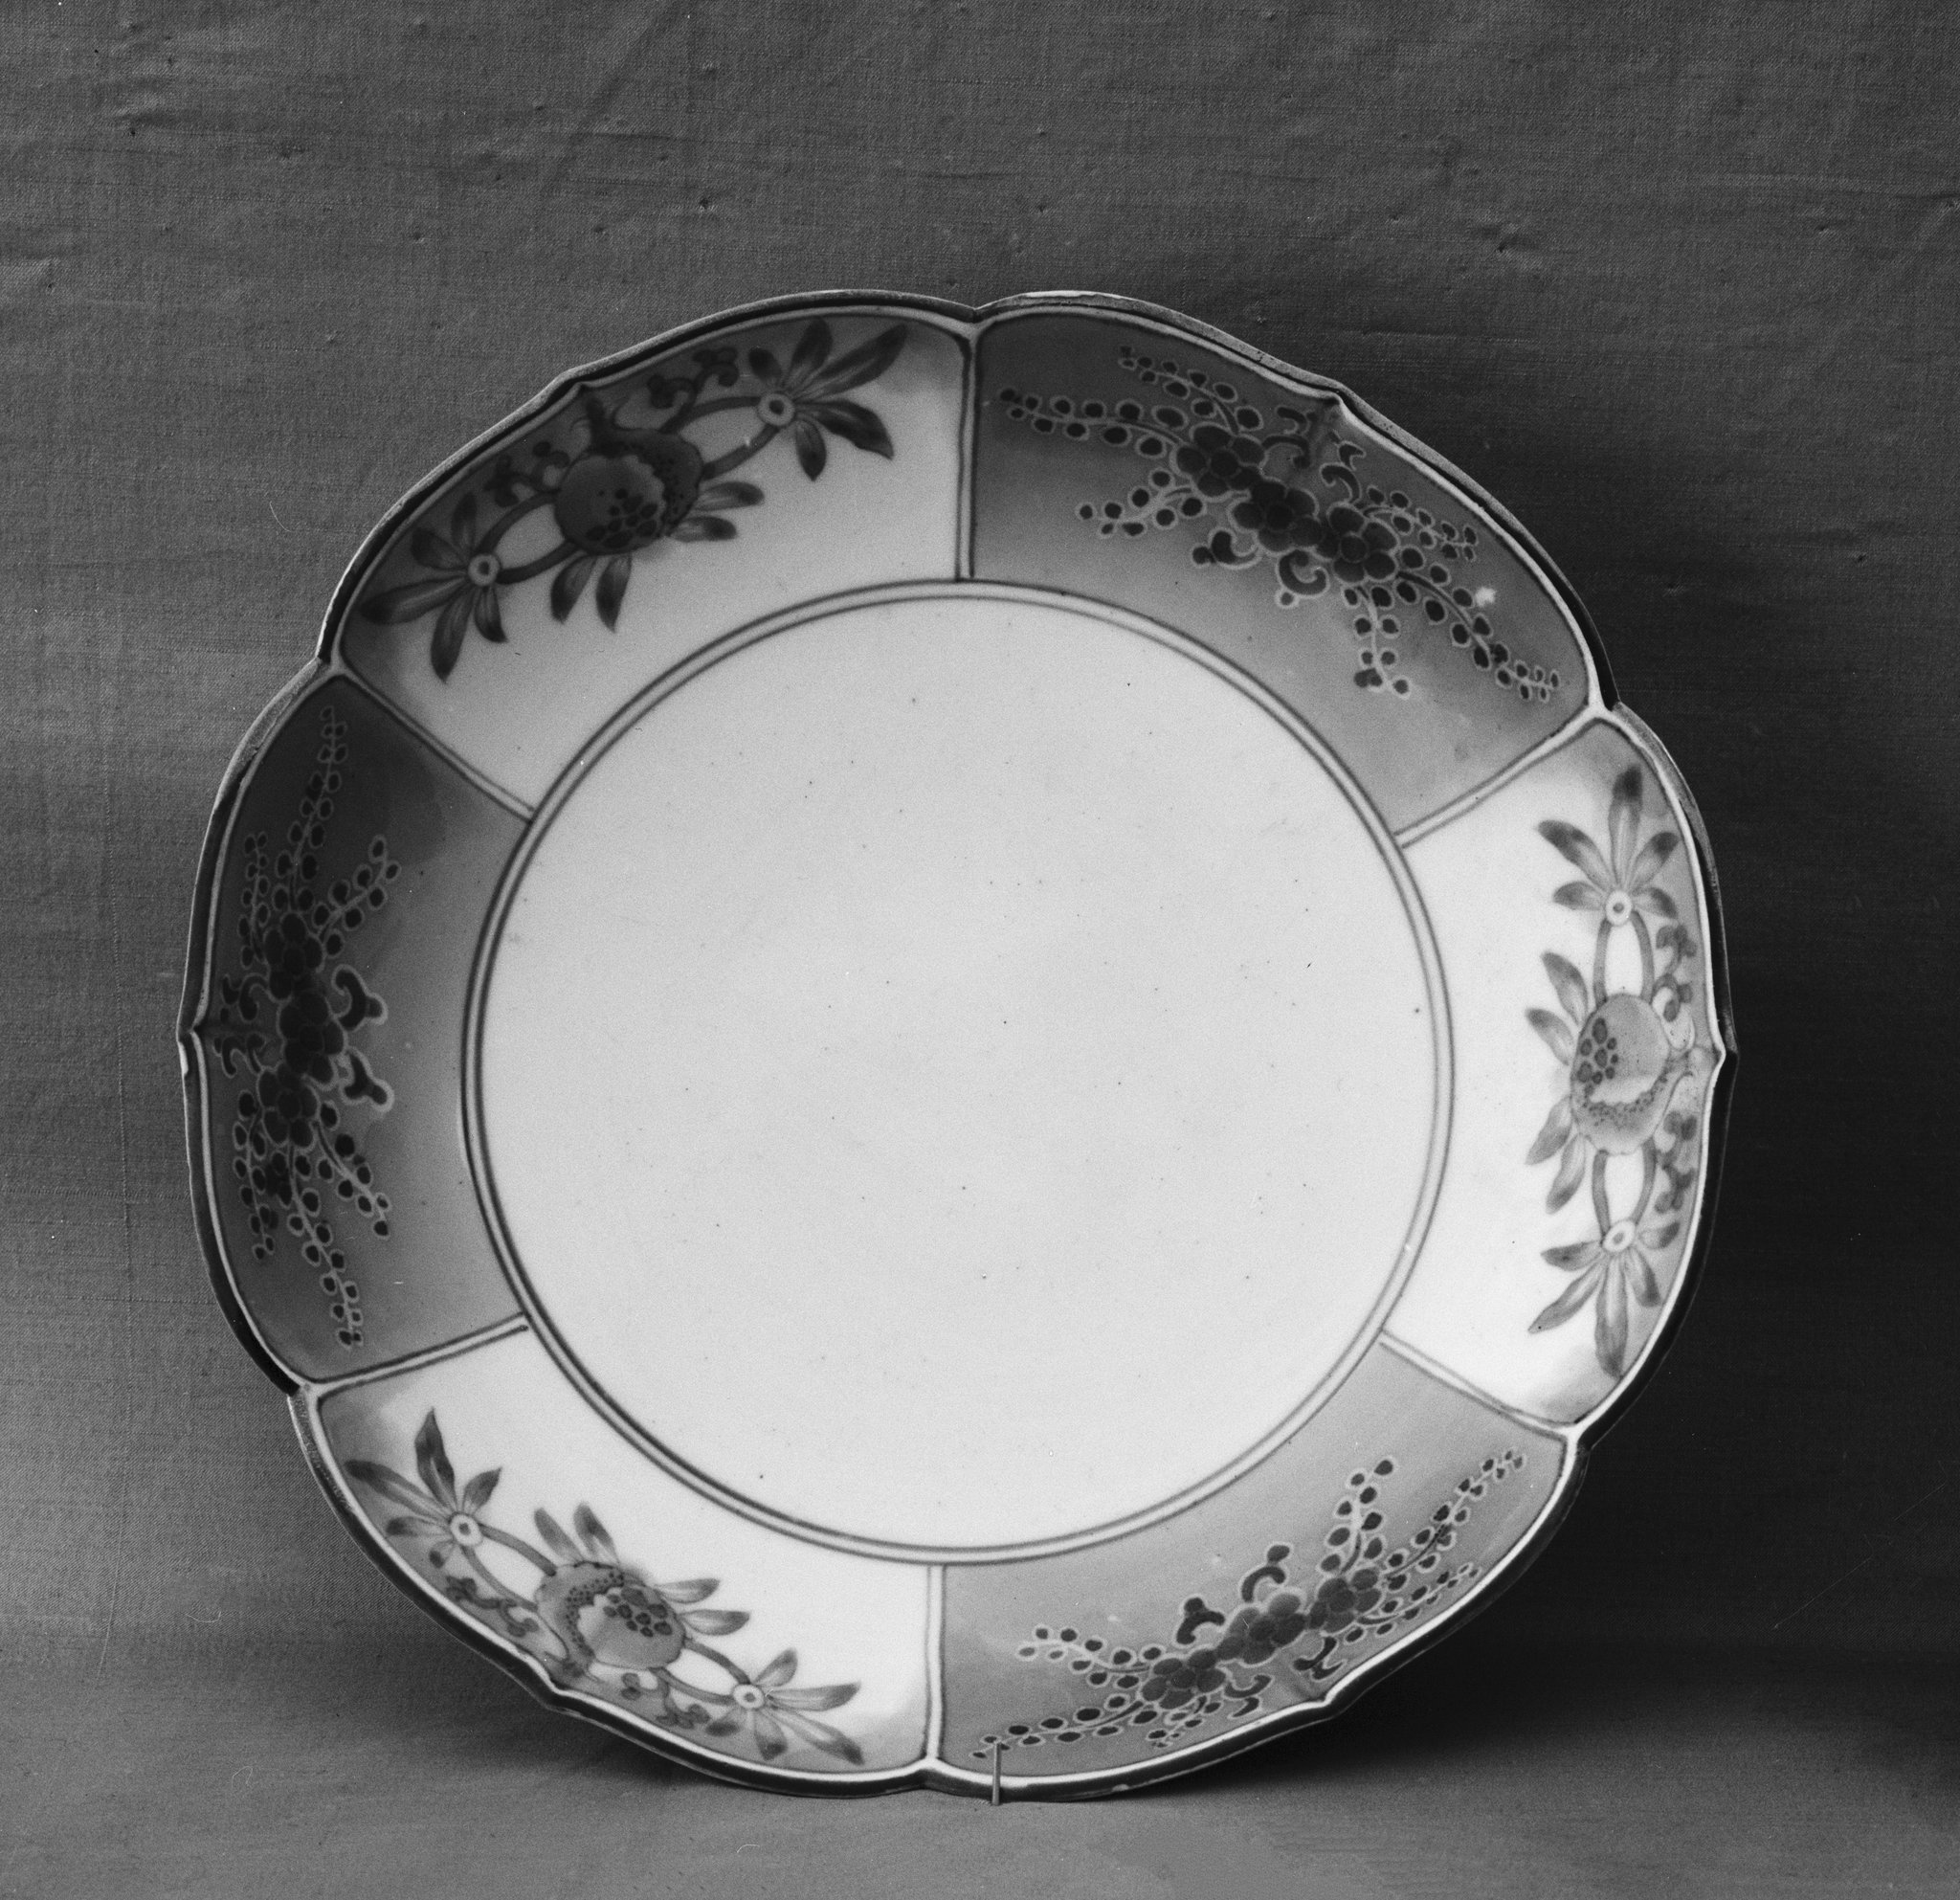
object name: dish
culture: japanese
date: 1800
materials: glaze, porcelain